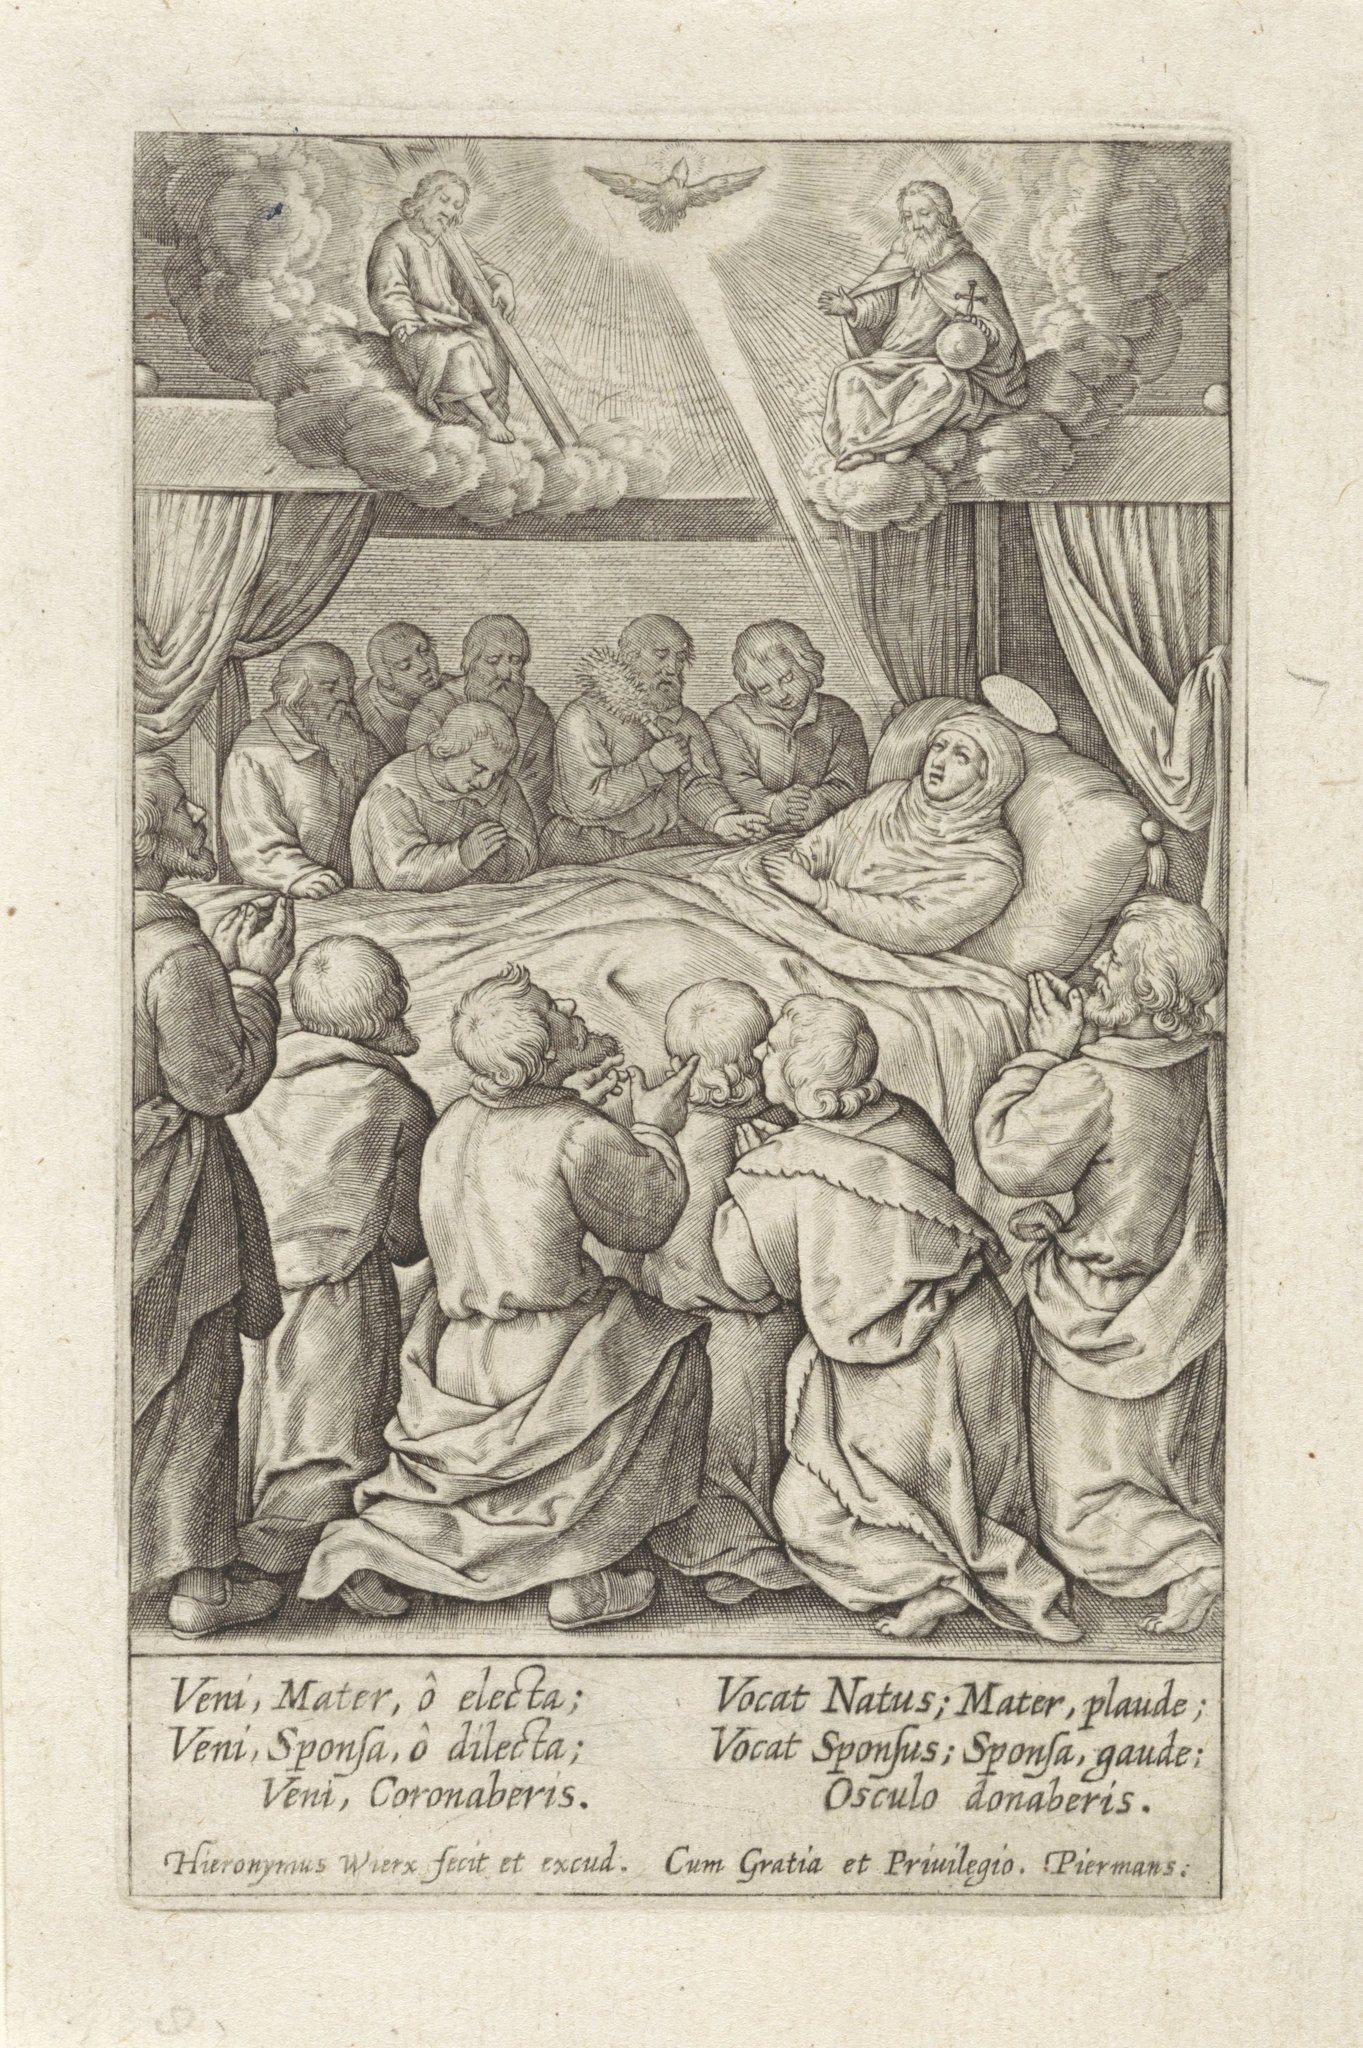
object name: print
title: Vita Deiparæ Virginis Mariæ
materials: paper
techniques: engraving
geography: antwerp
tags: the dormition: mary on her deathbed; the apostles are gathered around her (john the evangelist may be shown sleeping or dreaming) (+ holy trinity)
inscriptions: collector's mark: Lugt 2228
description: Maria ligt op bed. Rond haar bed bidden de apostelen. Boven in de hemel de Drieëenheid. In de marge een zesregelig onderschrift, in twee kolommen, in het Latijn.